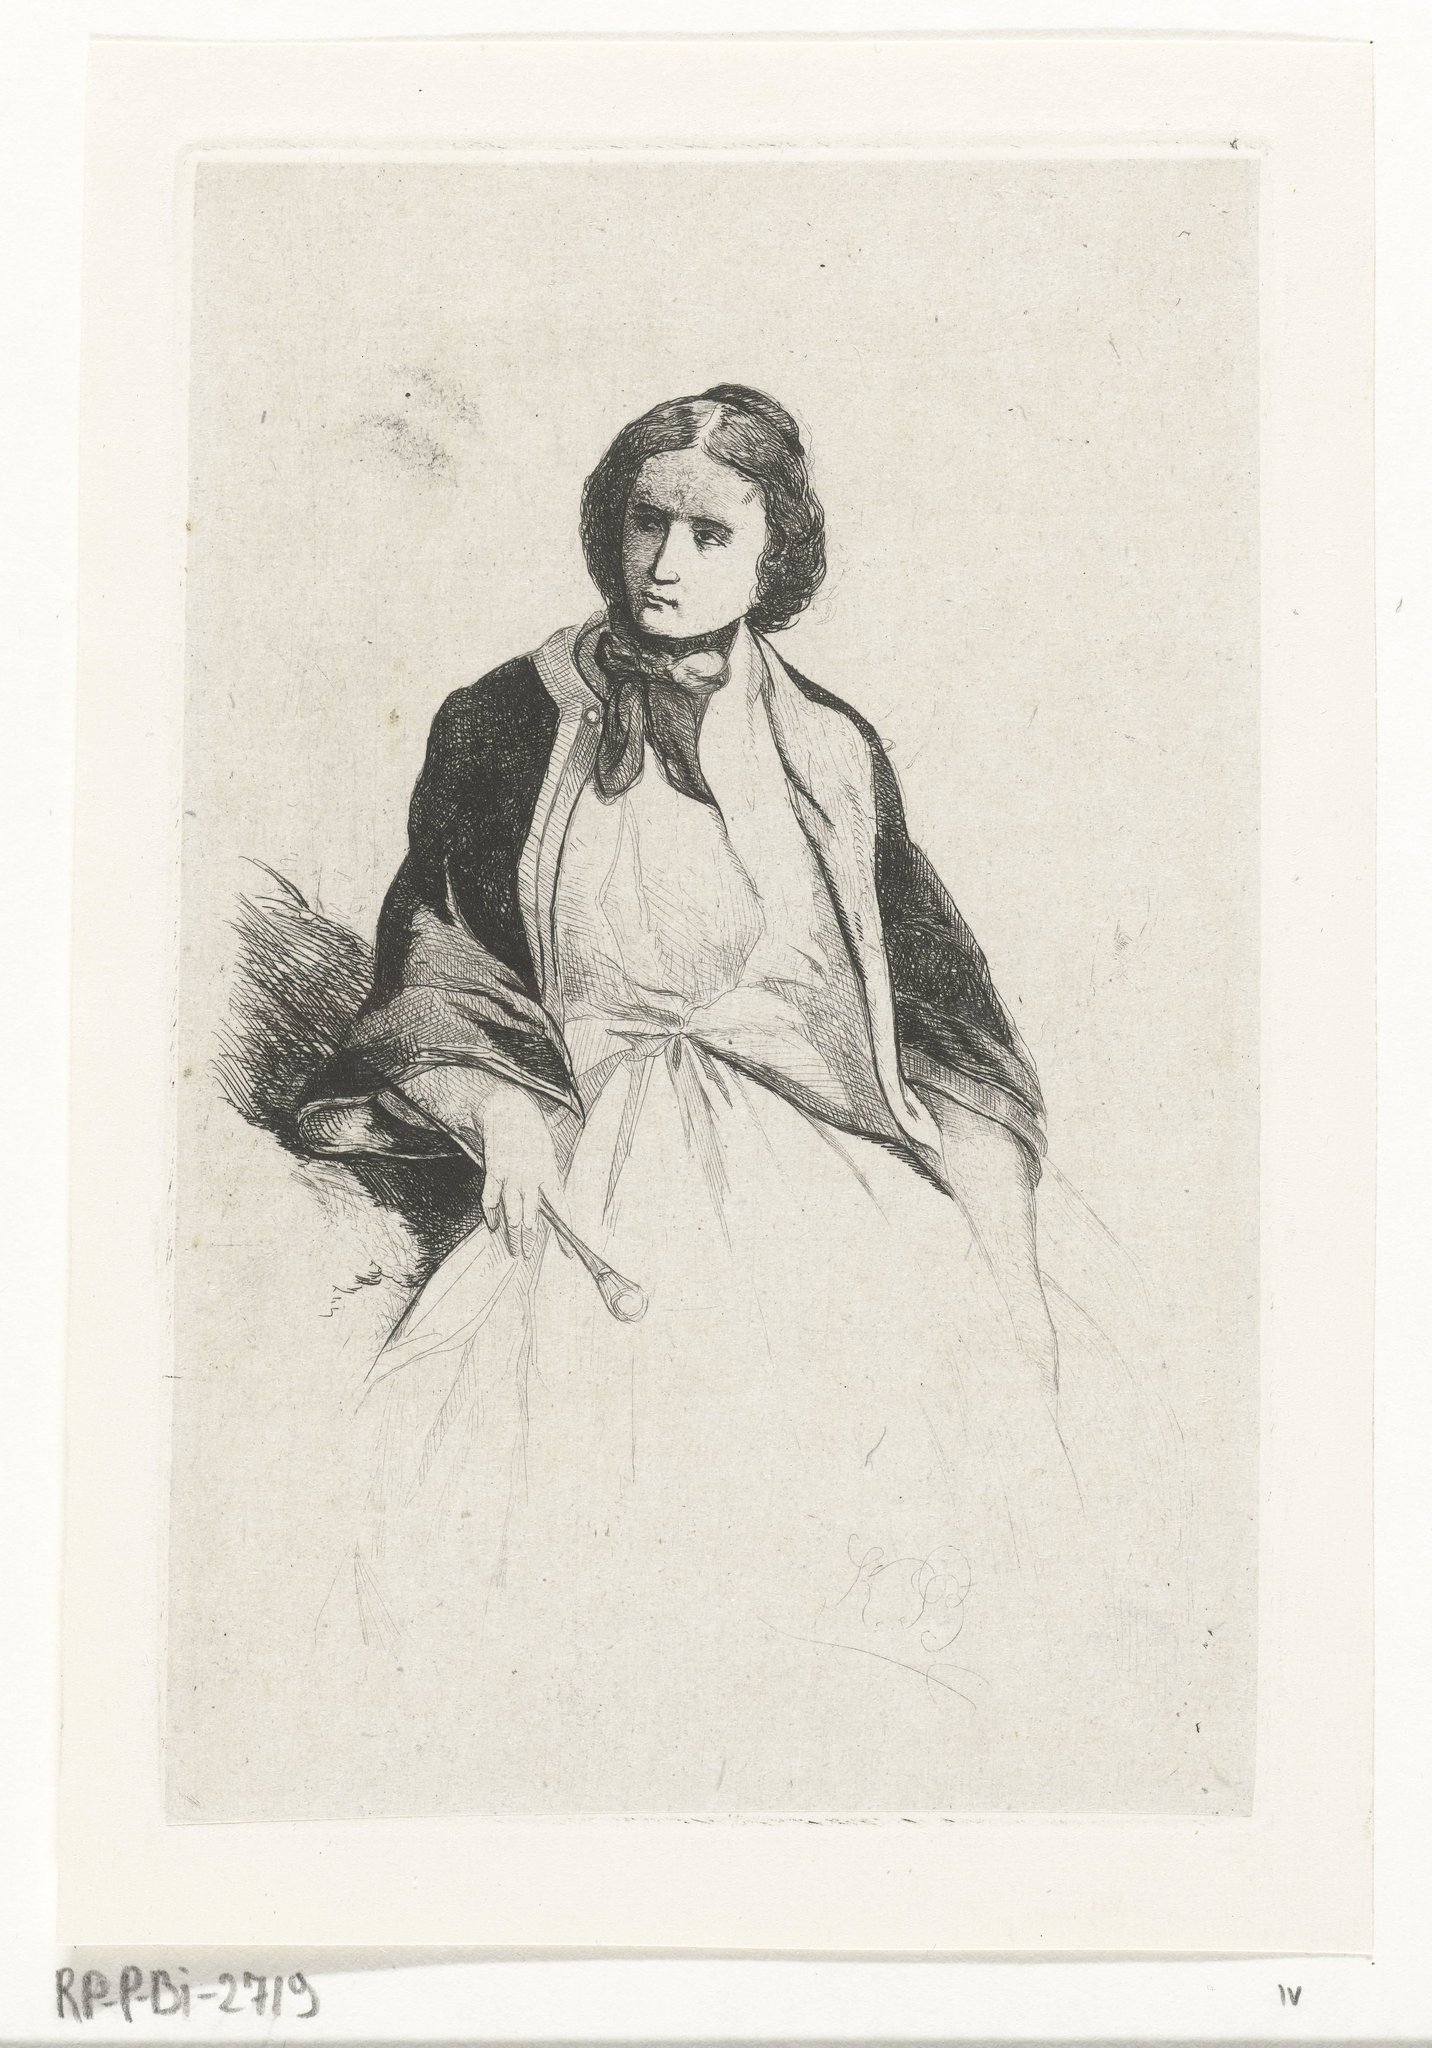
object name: print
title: Zittende vrouw met rijzweep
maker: karel frederik bombled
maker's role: draughtsman, print maker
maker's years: 1822-1902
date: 1832-1902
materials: paper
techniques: etching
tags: sitting figure, the (nude) human figure; 'corpo humano' (ripa) (+ adult female (human being)), whip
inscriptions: collector's mark: Lugt 2228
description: Een volwassen vrouw in 19de eeuwse kleding. Ze zit en kijkt naar rechts. Ze heeft een rijzweep in de rechterhand.